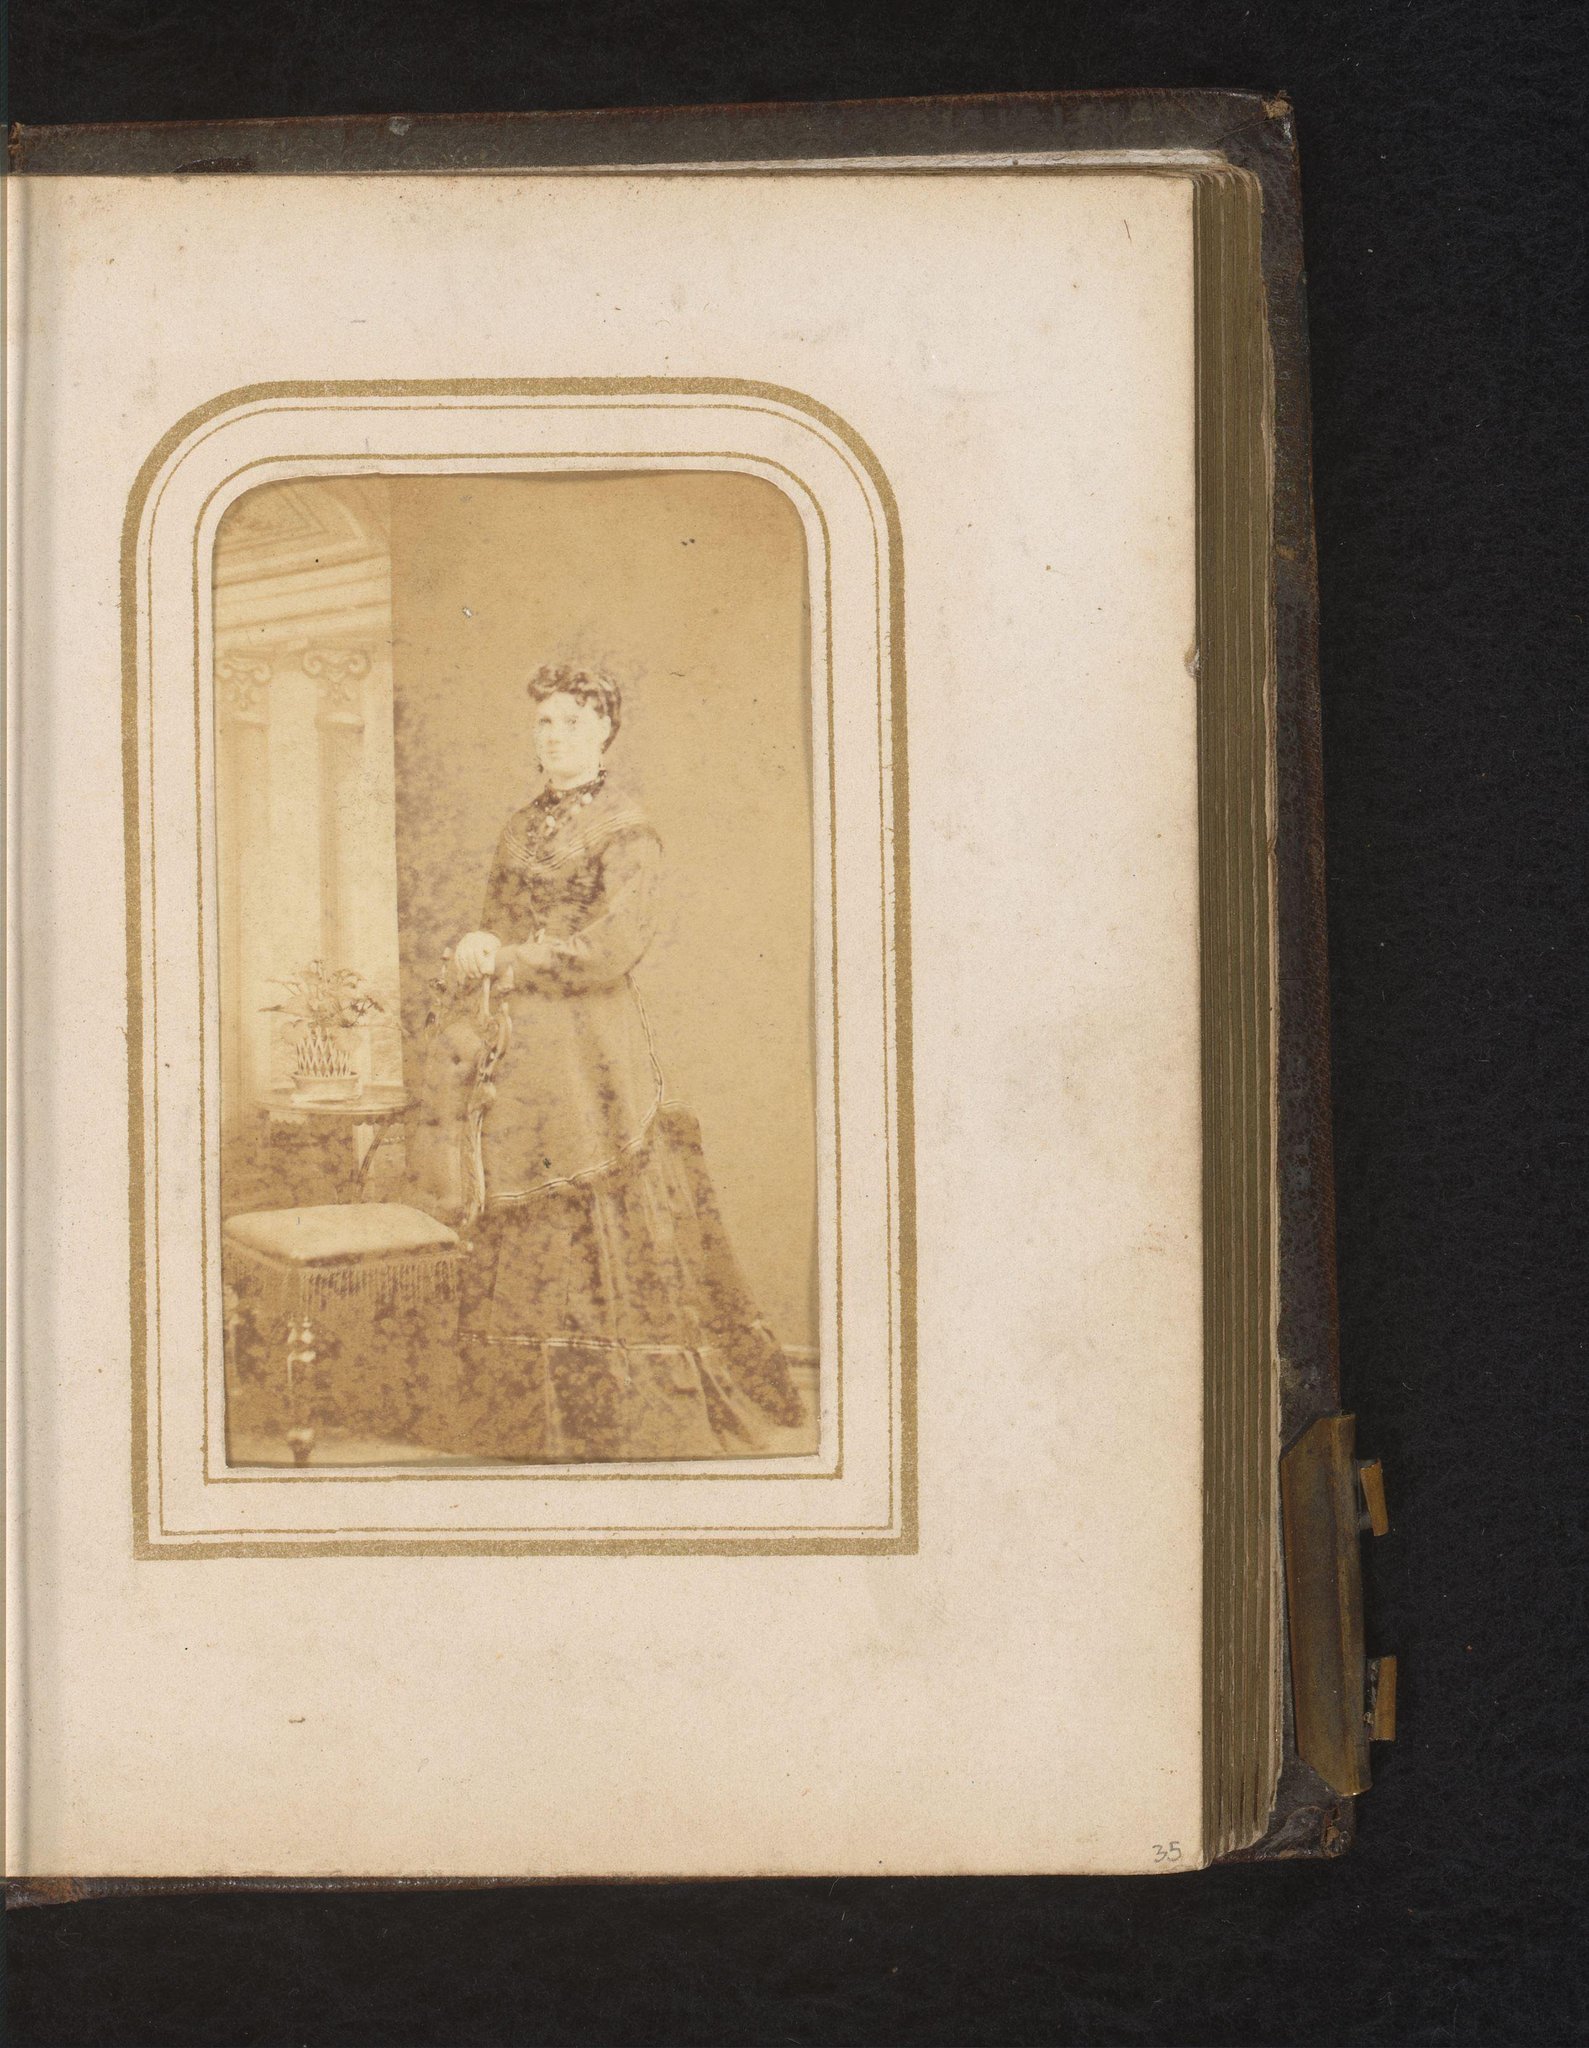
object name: album leaf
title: Portret van een vrouw, staand bij een stoel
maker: Anonymous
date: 1860-1890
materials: cardboard, paper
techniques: albumen print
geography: great britain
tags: historical persons - bb - woman, standing figure - aa - female human figure, chair